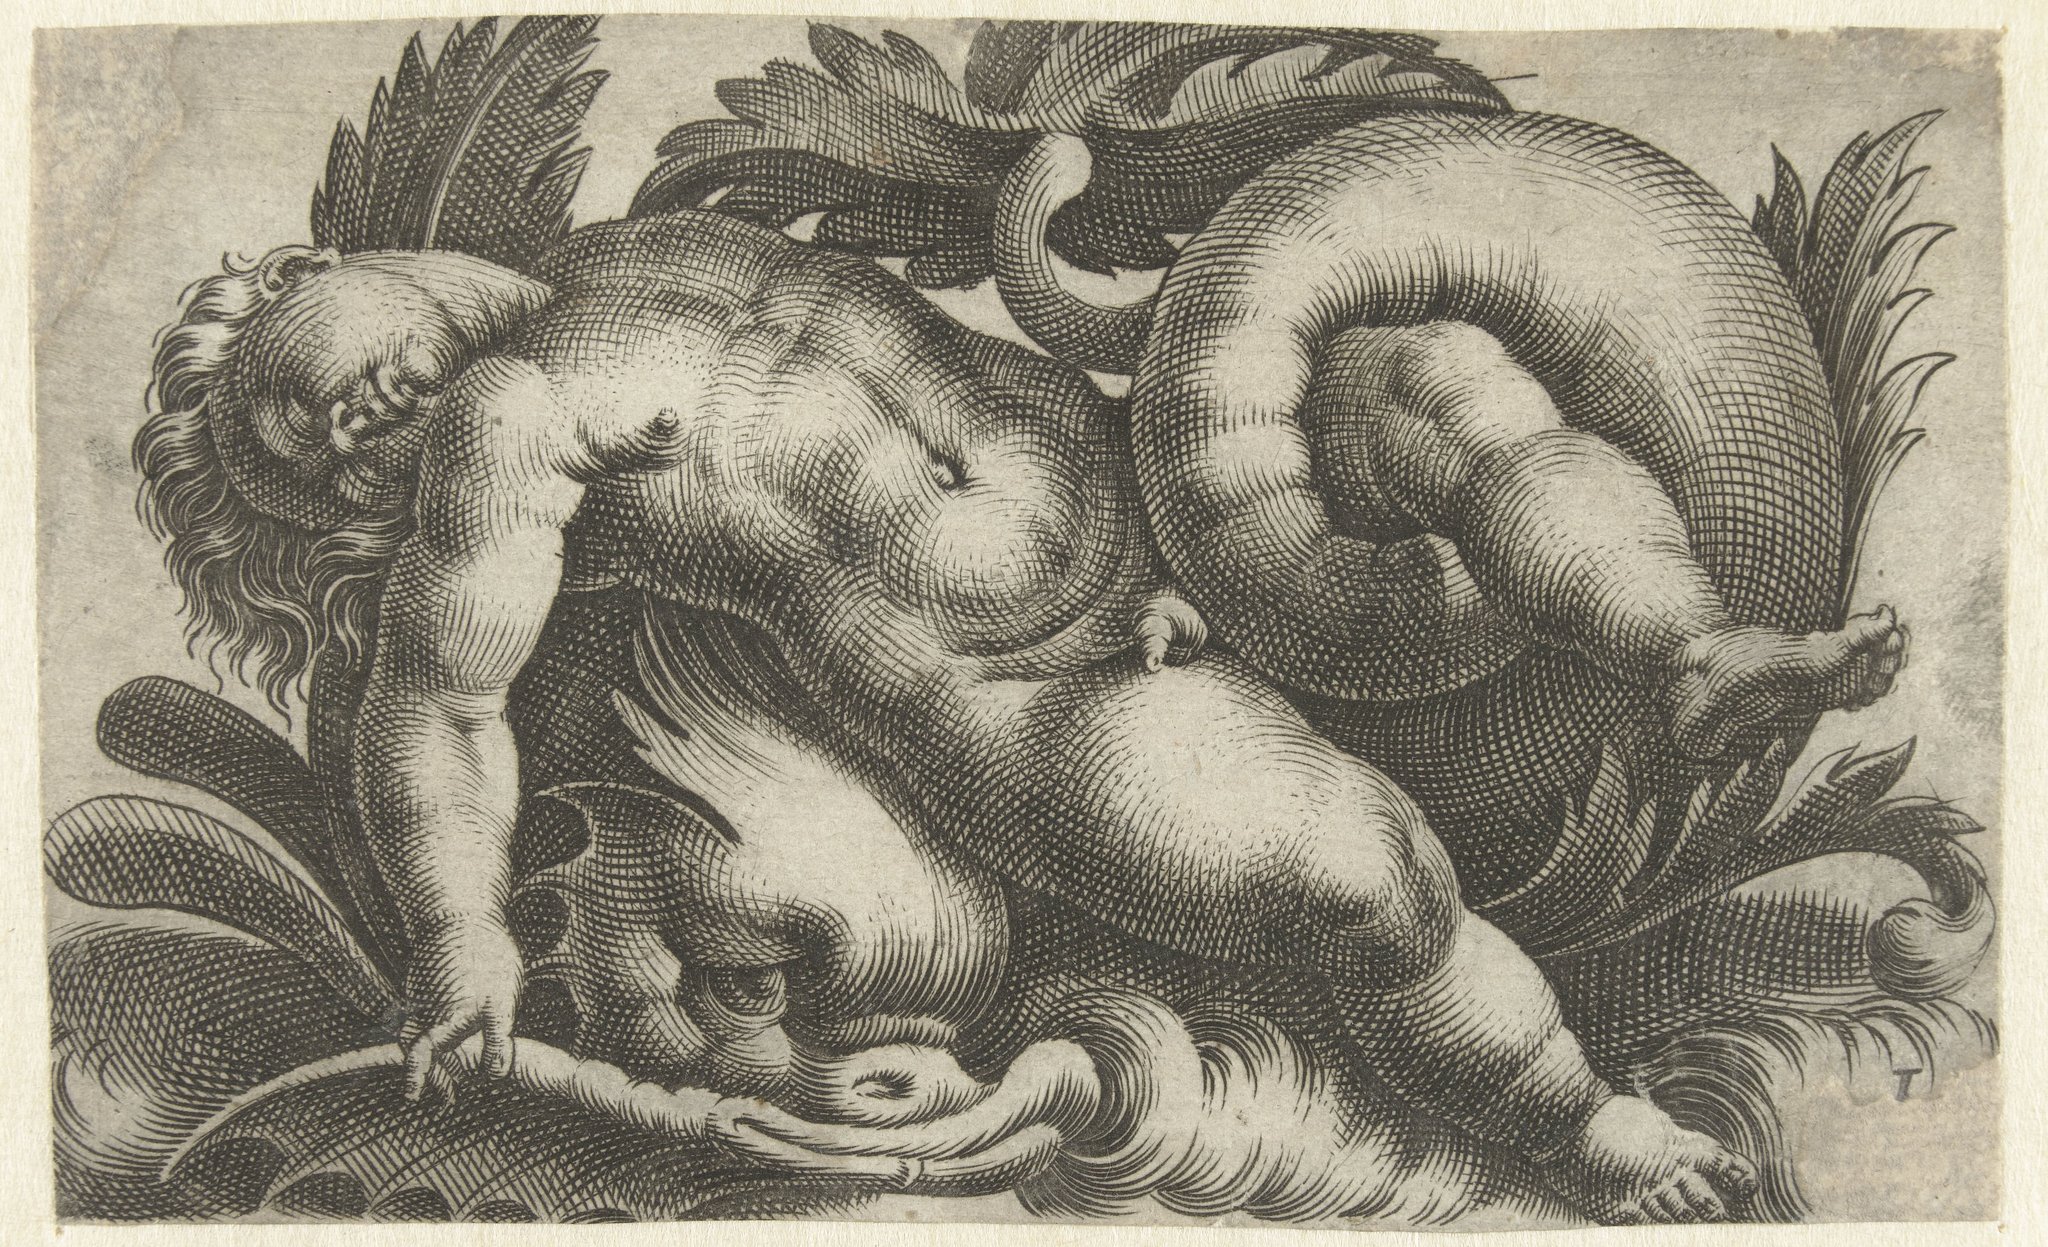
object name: print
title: Slapende putto op dolfijn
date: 1580-1608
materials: paper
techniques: engraving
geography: italy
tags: sleeping; unconsciousness